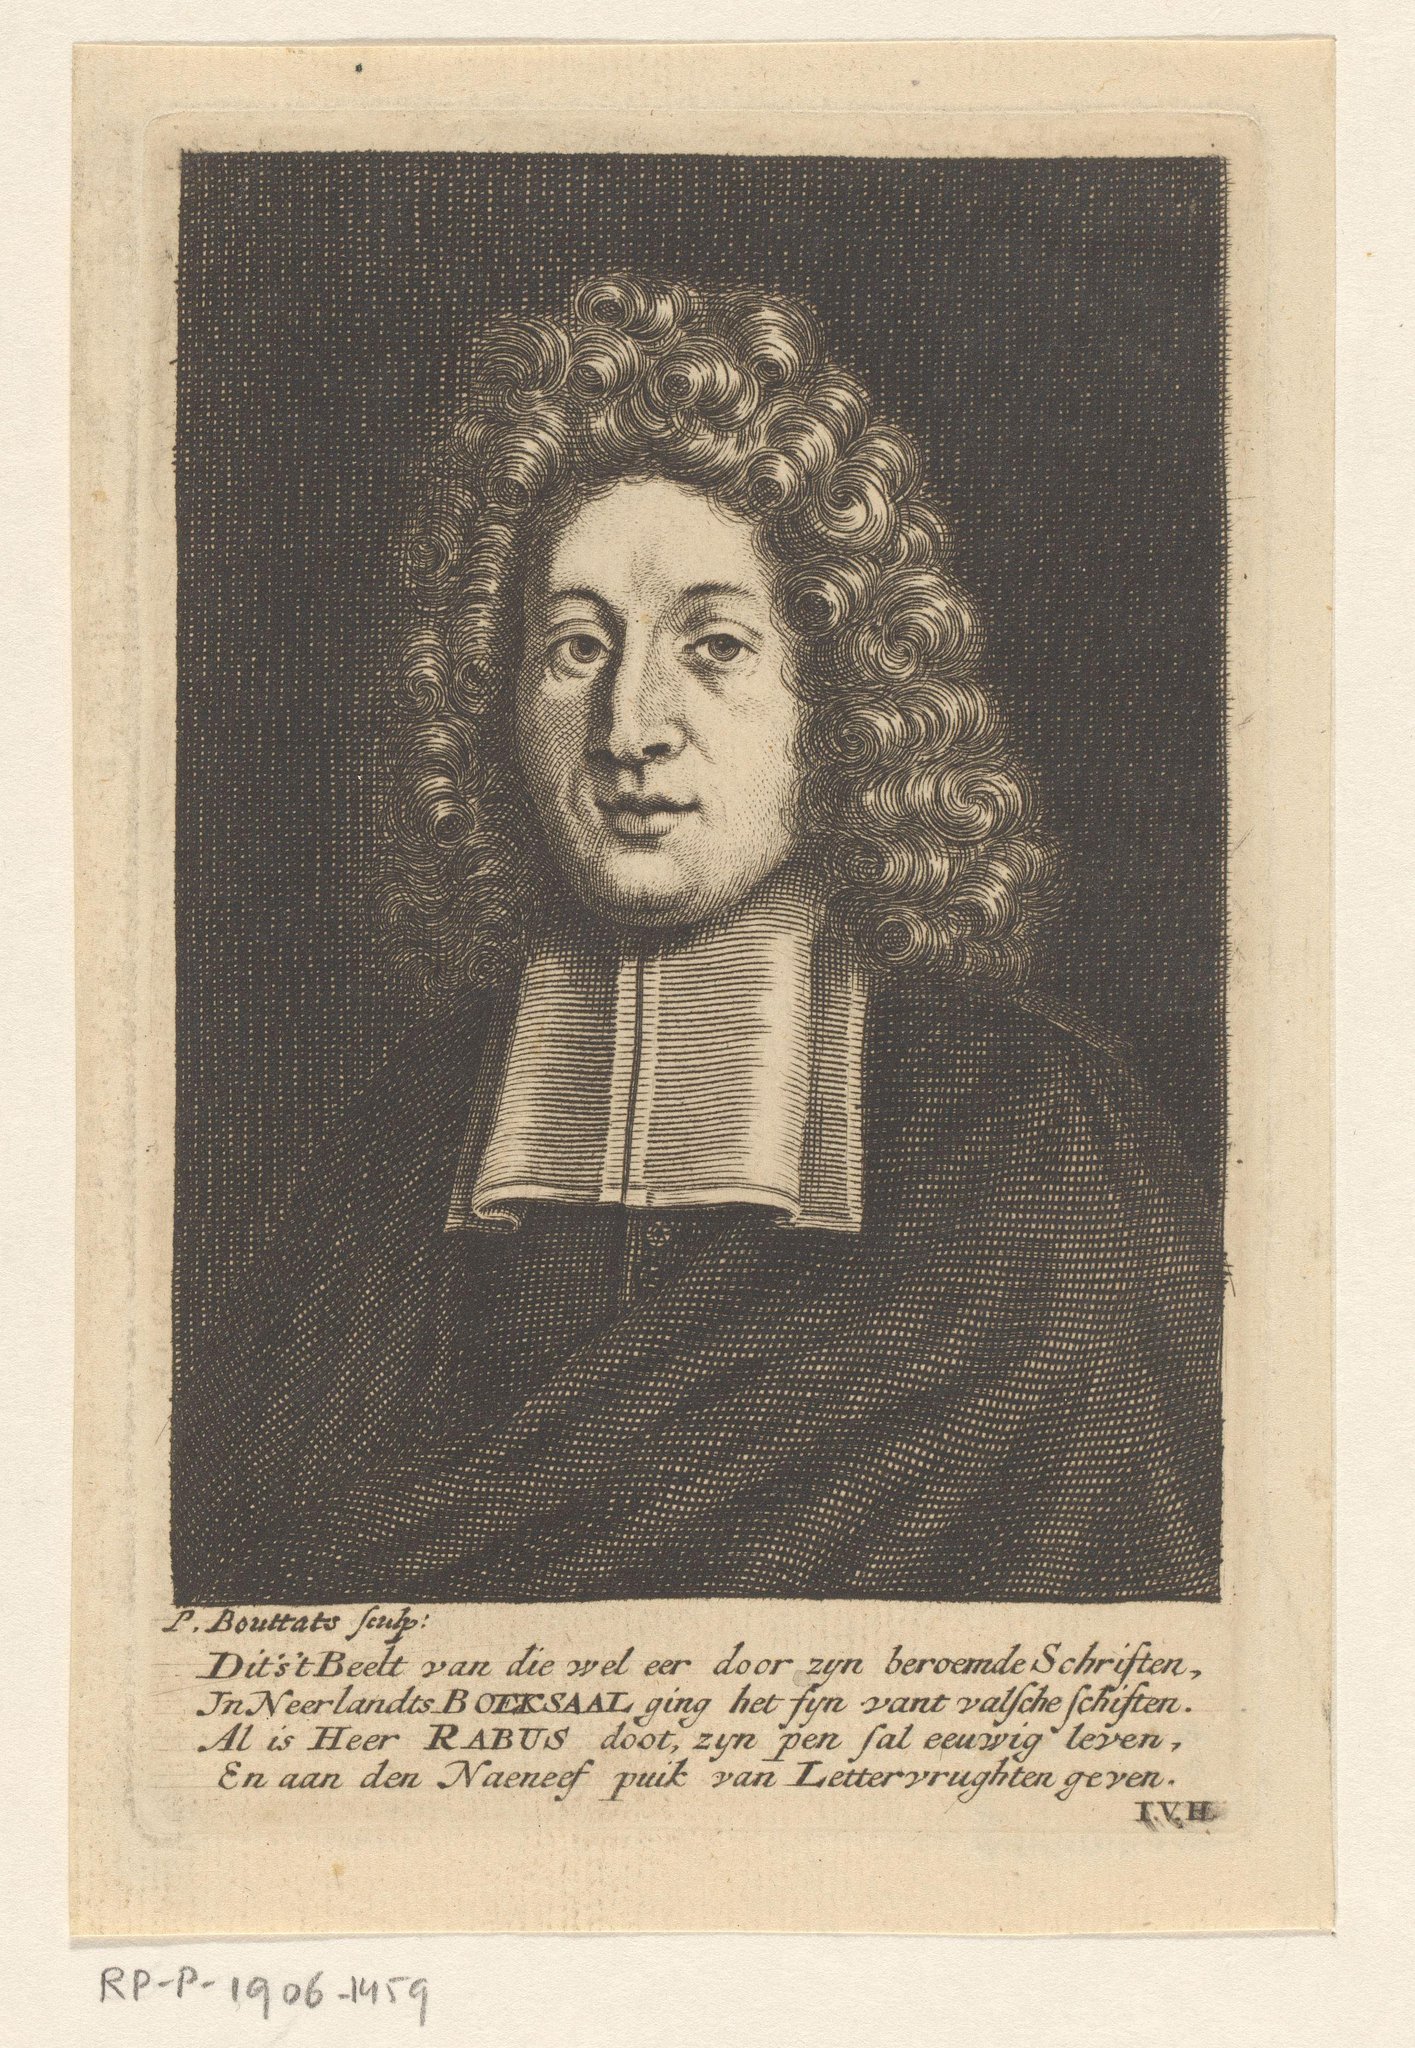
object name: print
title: Portret van Pieter Rabus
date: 1702-1731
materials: paper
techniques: engraving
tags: pieter rabus, historical persons, portrait of a writer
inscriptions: signature: ‘P. Bouttats sculp’, monogram: ‘I.V.M.’, collector's mark: Lugt 2228, poem: ‘Dit is t Beeld van die wel eer door zijn beroemde Schriften / in Neerlandts BOEKSAAL ging het fijn van 't valsche schiften / Al is Heer Rabus doot, zyn pen sal eeuwig leven / En aan den Naeneef puik van Lettervrughten geven.’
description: Portret van de Nederlandse schrijver en dichter Pieter Rabus. Buste naar links. Rabus draagt een toga. Met Nederlands onderschrift: '' Dit is t Beeld van die wel eer door zijn beroemde Schriften in Neerlandts BOEKSAAL ging het fijn van 't valsche schiften. Al is Heer Rabus doot, zyn pen sal eeuwig leven en aan den Naeneef puik van Lettervrughten geven'.